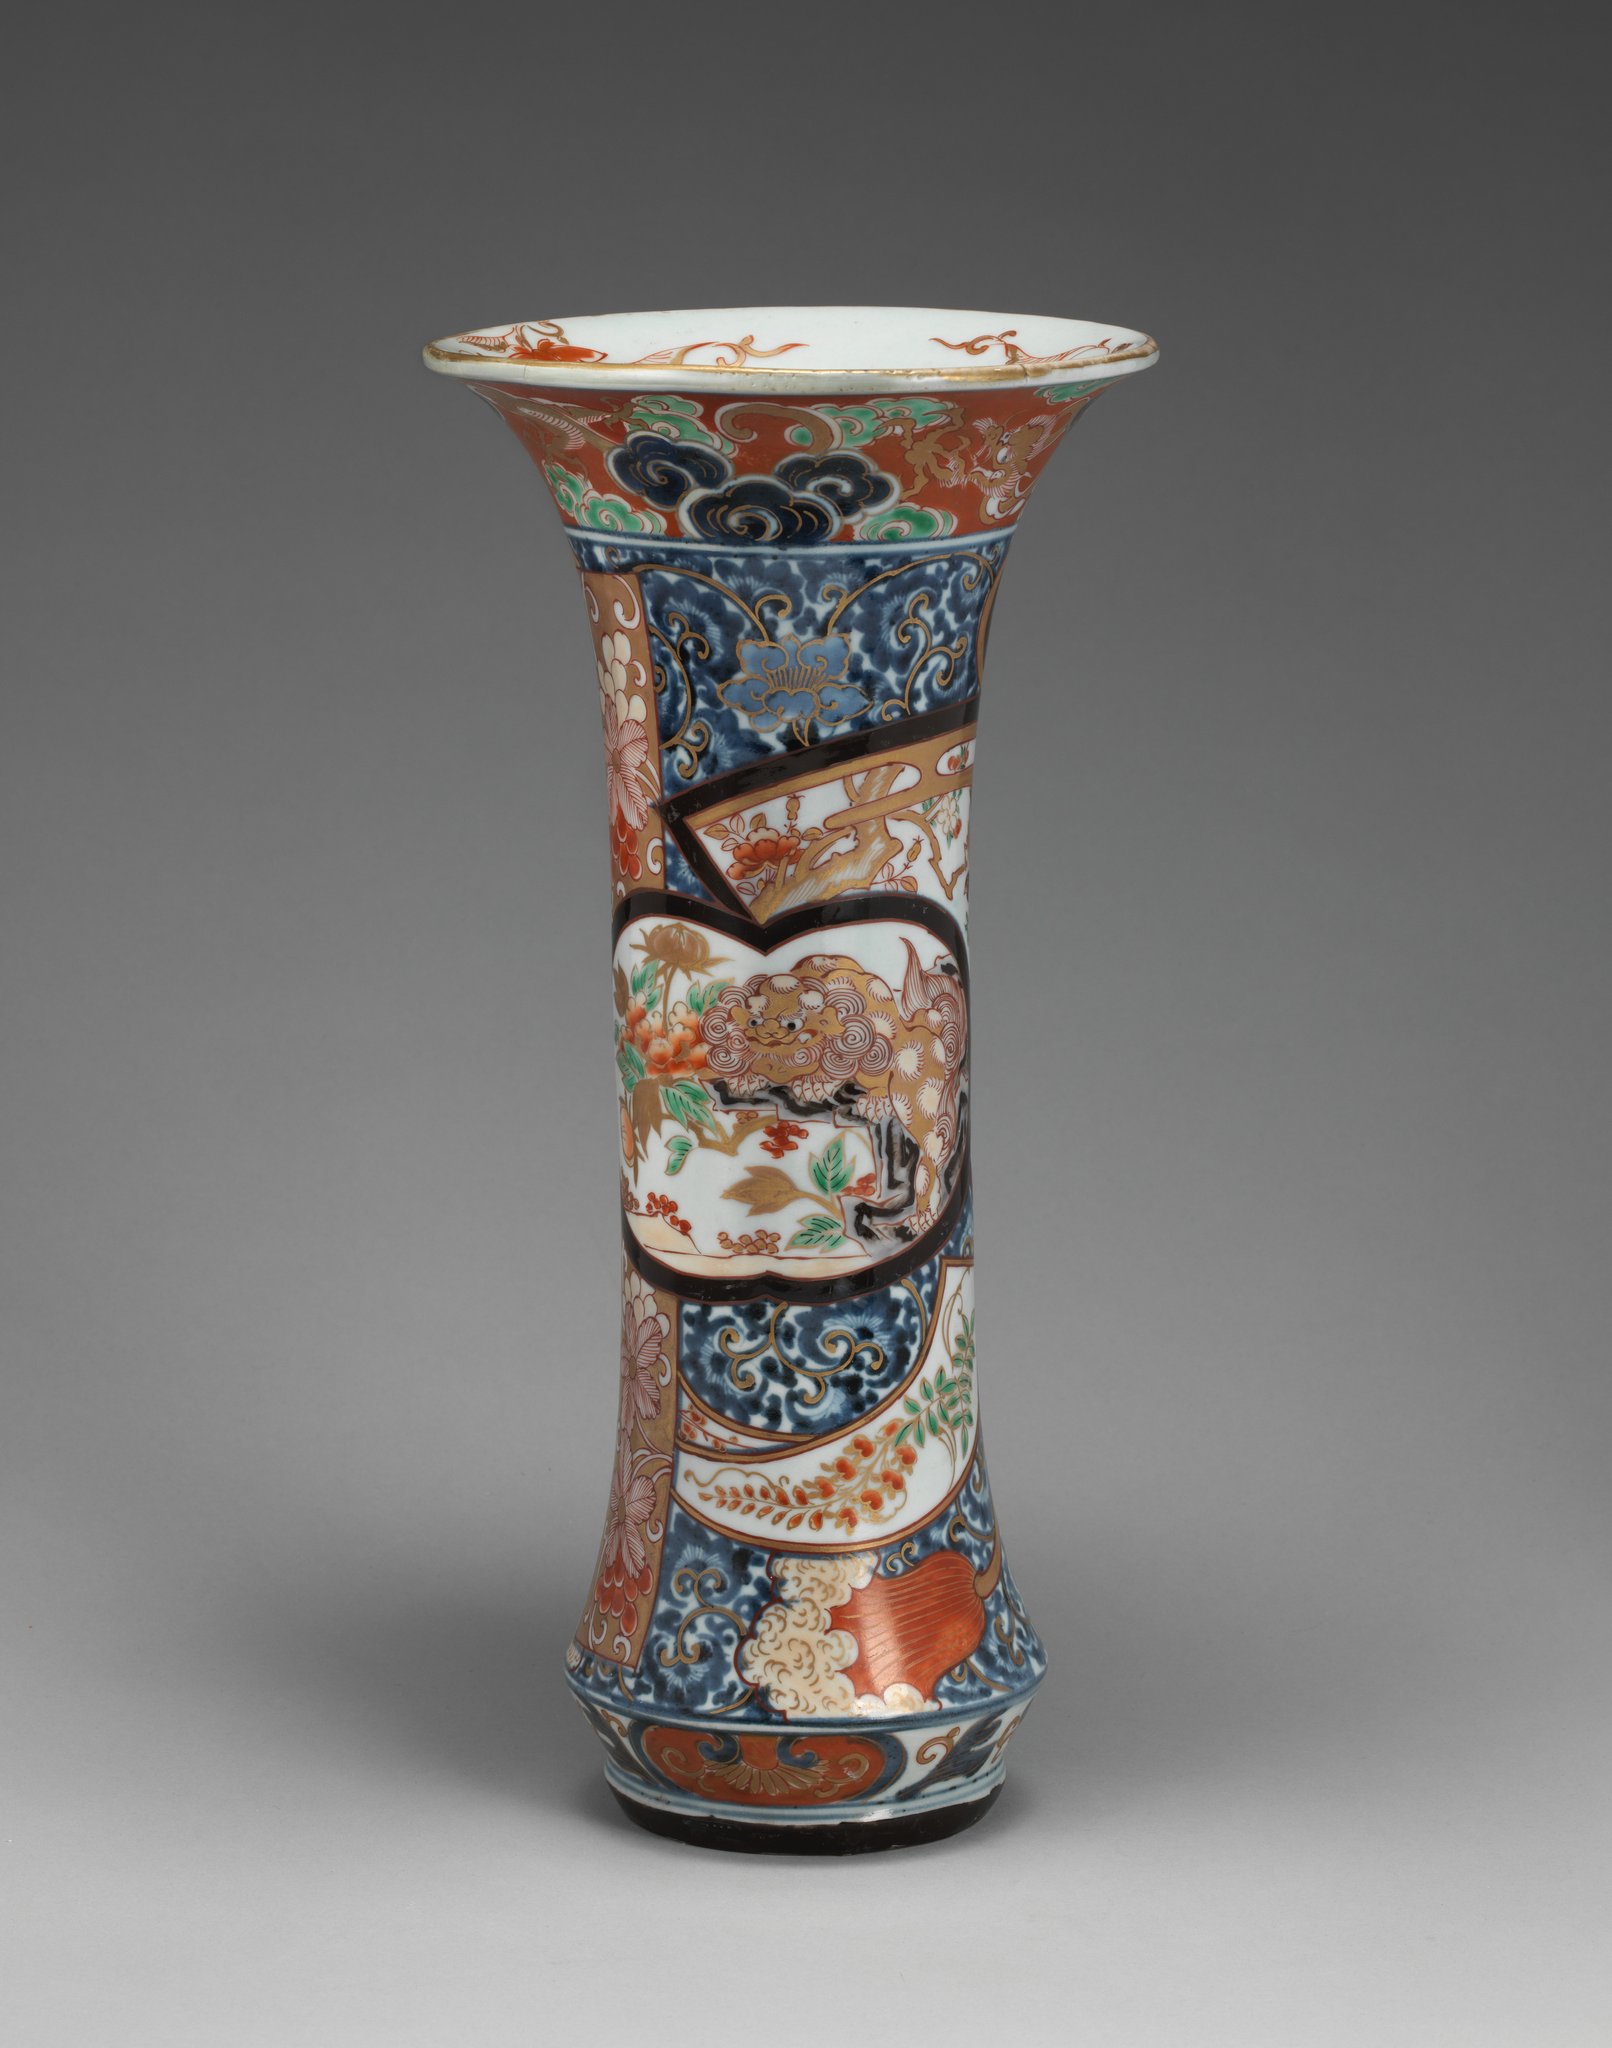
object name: vase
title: Beaker vase (part of an assembled garniture)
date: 1690-1720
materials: enamel, hard paste porcelain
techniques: gilding, overglaze, underglaze